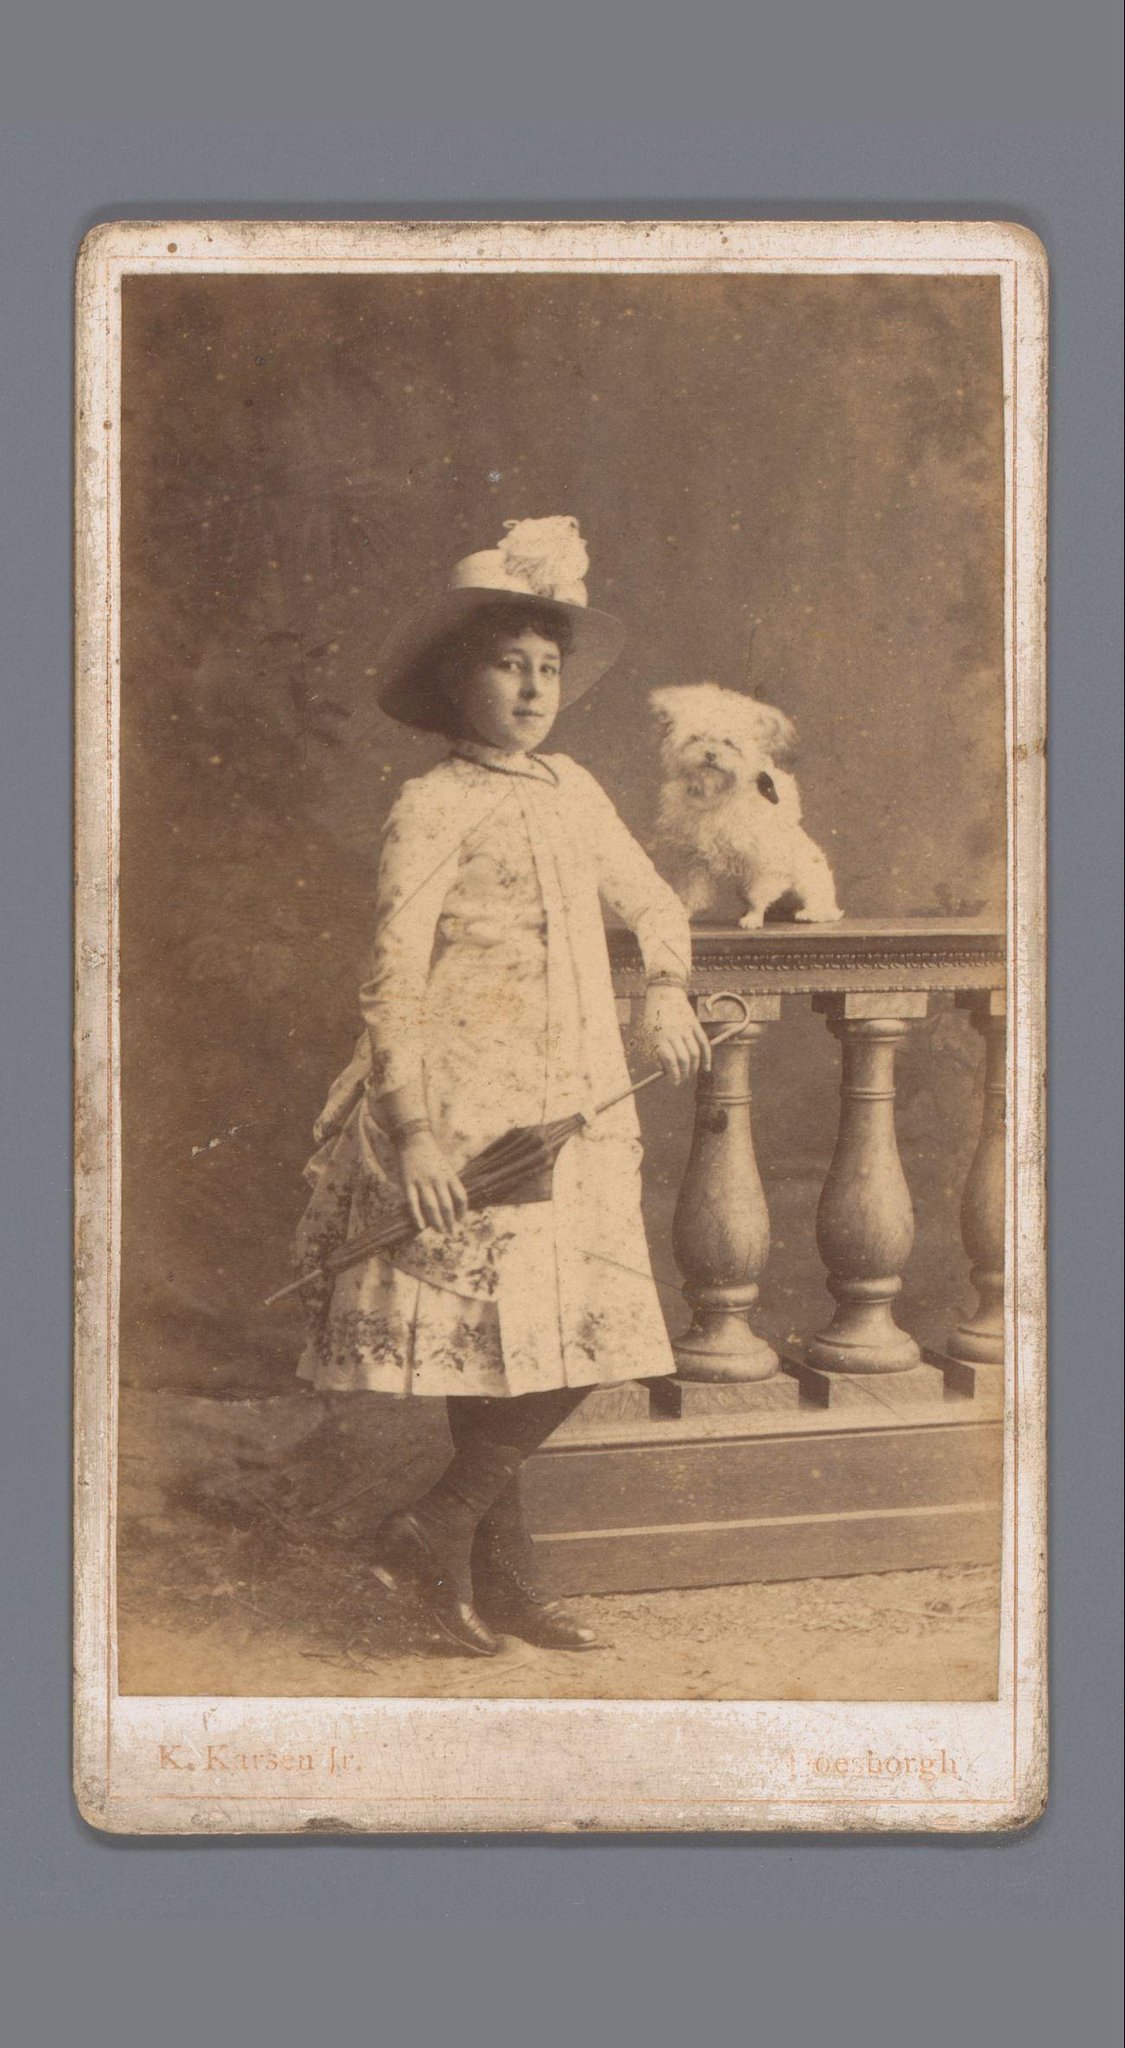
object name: carte de visite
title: Portret van een onbekend meisje met een paraplu in de hand met daarnaast een kleine hond op een balustrade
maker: kars karsen jr.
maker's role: fotograaf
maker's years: 1852-1935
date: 1883-1900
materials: cardboard, paper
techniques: albumen print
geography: doesburg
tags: historical persons, balustrade, umbrella, dog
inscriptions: inscription: ‘K. KARSEN Jr/ PHOTOGRAAF/ Veerpoortstraat/ DOESBORGH./ Voor nabestelling worden alle/ negatieven bewaard./ Photographie Instantanée.’